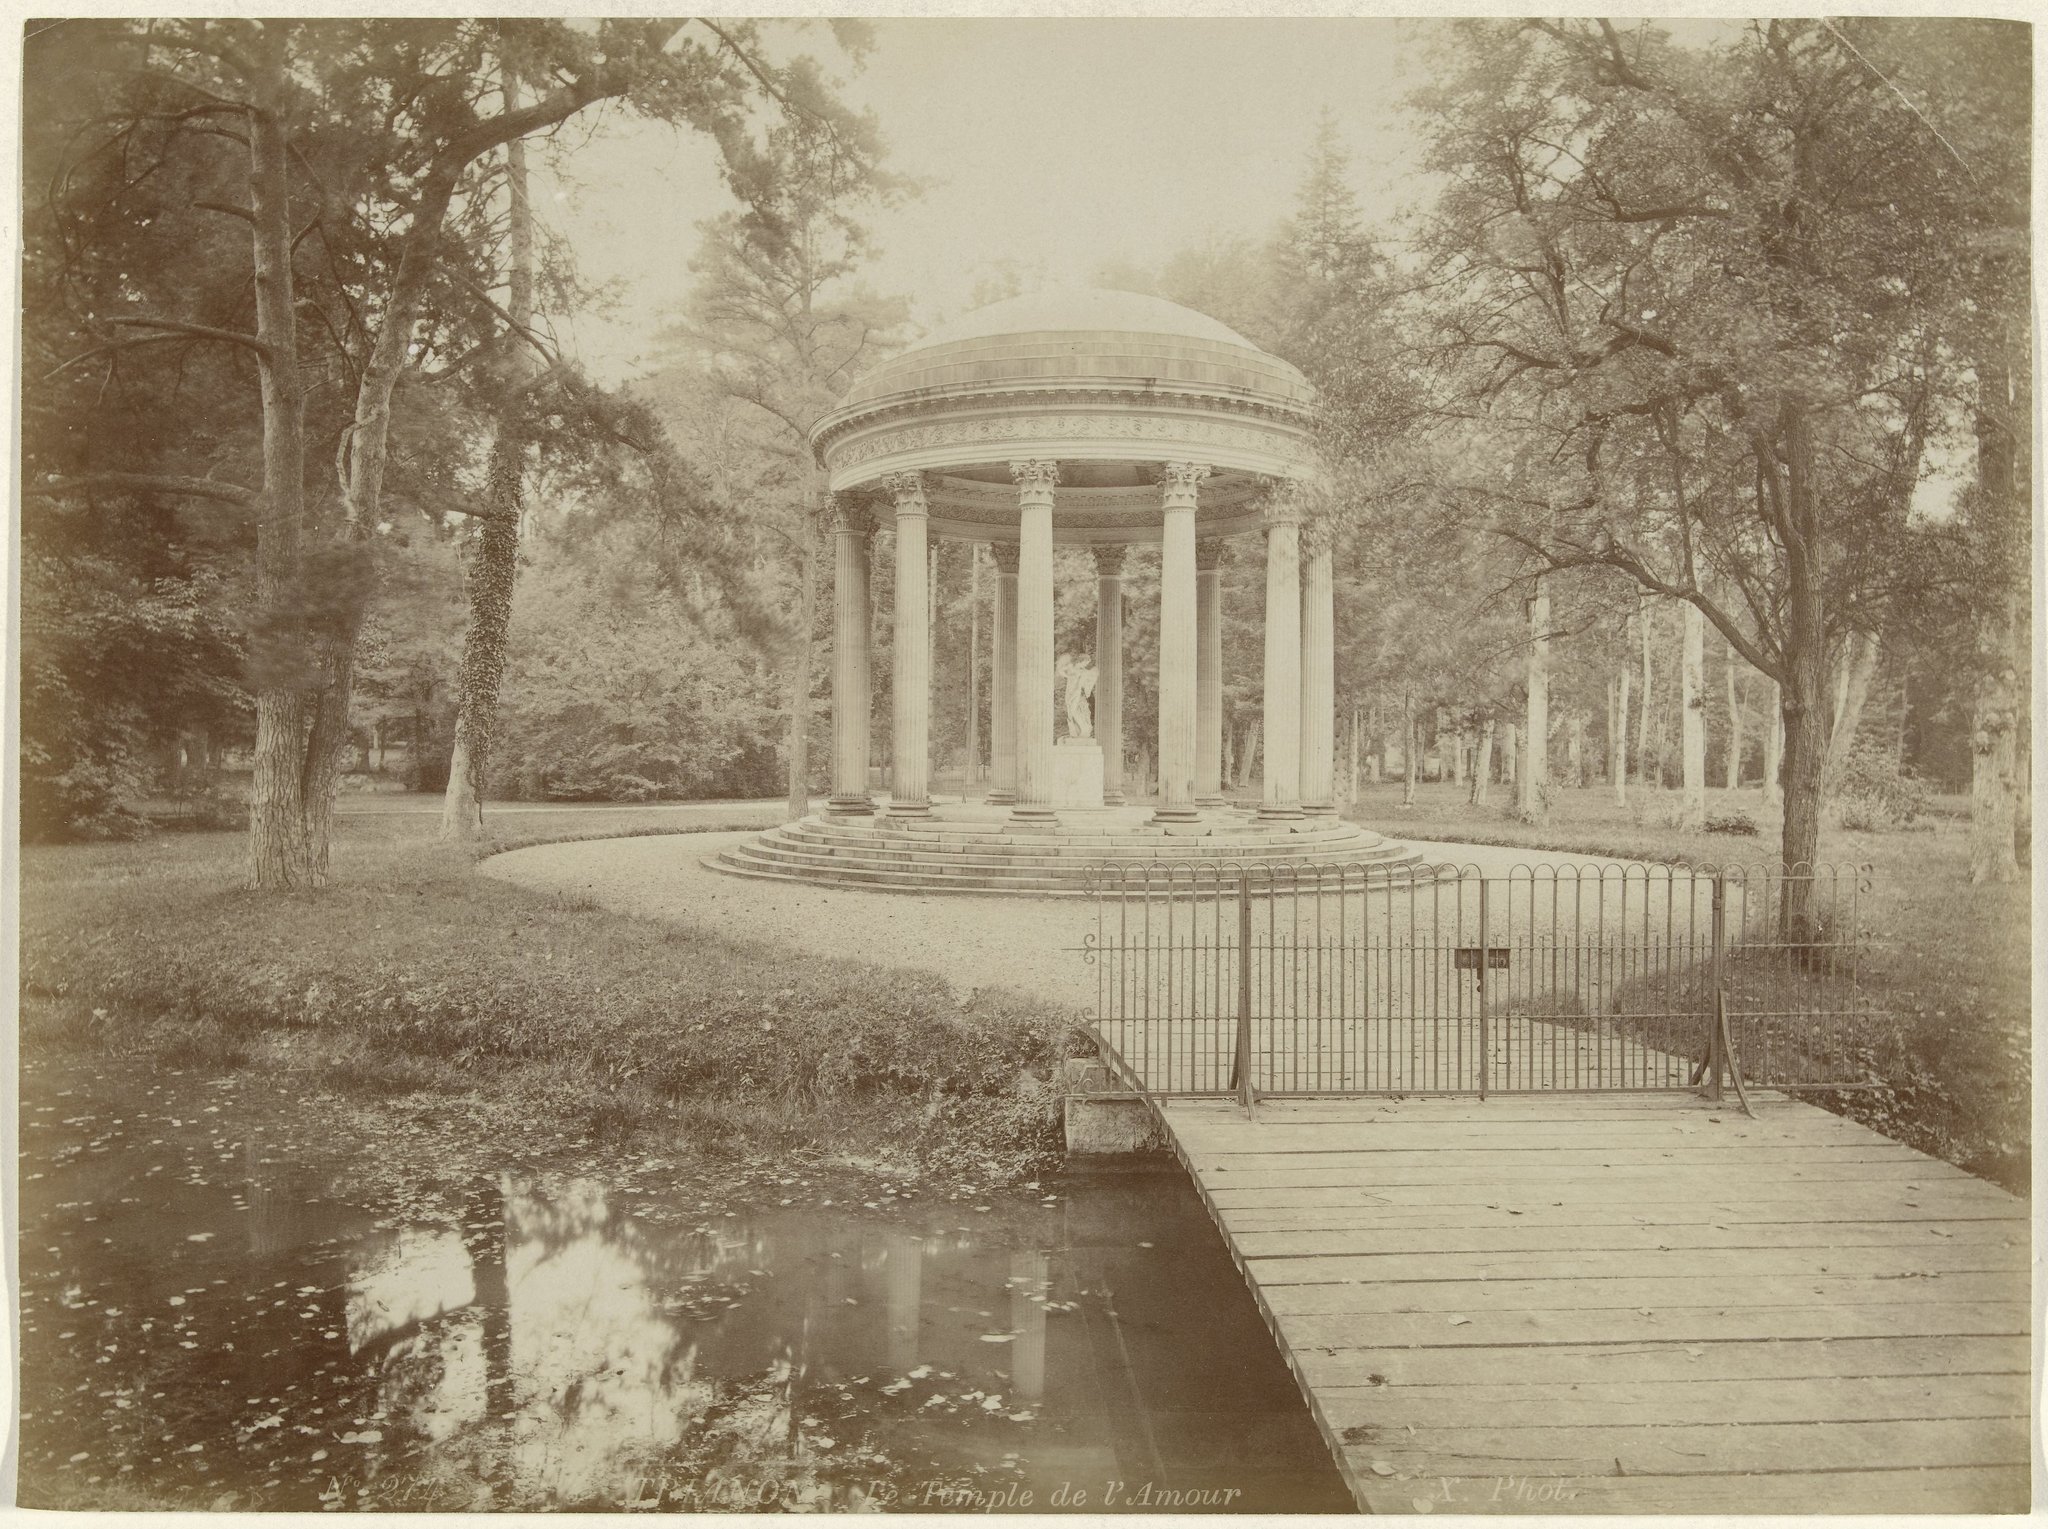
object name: photograph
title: Tempel van de Liefde nabij het Klein Trianon in de tuinen van Versailles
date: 1887-1900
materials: paper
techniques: albumen print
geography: versailles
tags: french or architectonic garden; formal garden, temple, shrine ~ non-christian religions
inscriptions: inscription: ‘No 274 Trianon. - Le Temple de l'Amour X. Phot.’, number: ‘14’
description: Tussen 1887 en ca. 1900 werkten Neurdein frères onder andere onder de naam 'X phot.'.